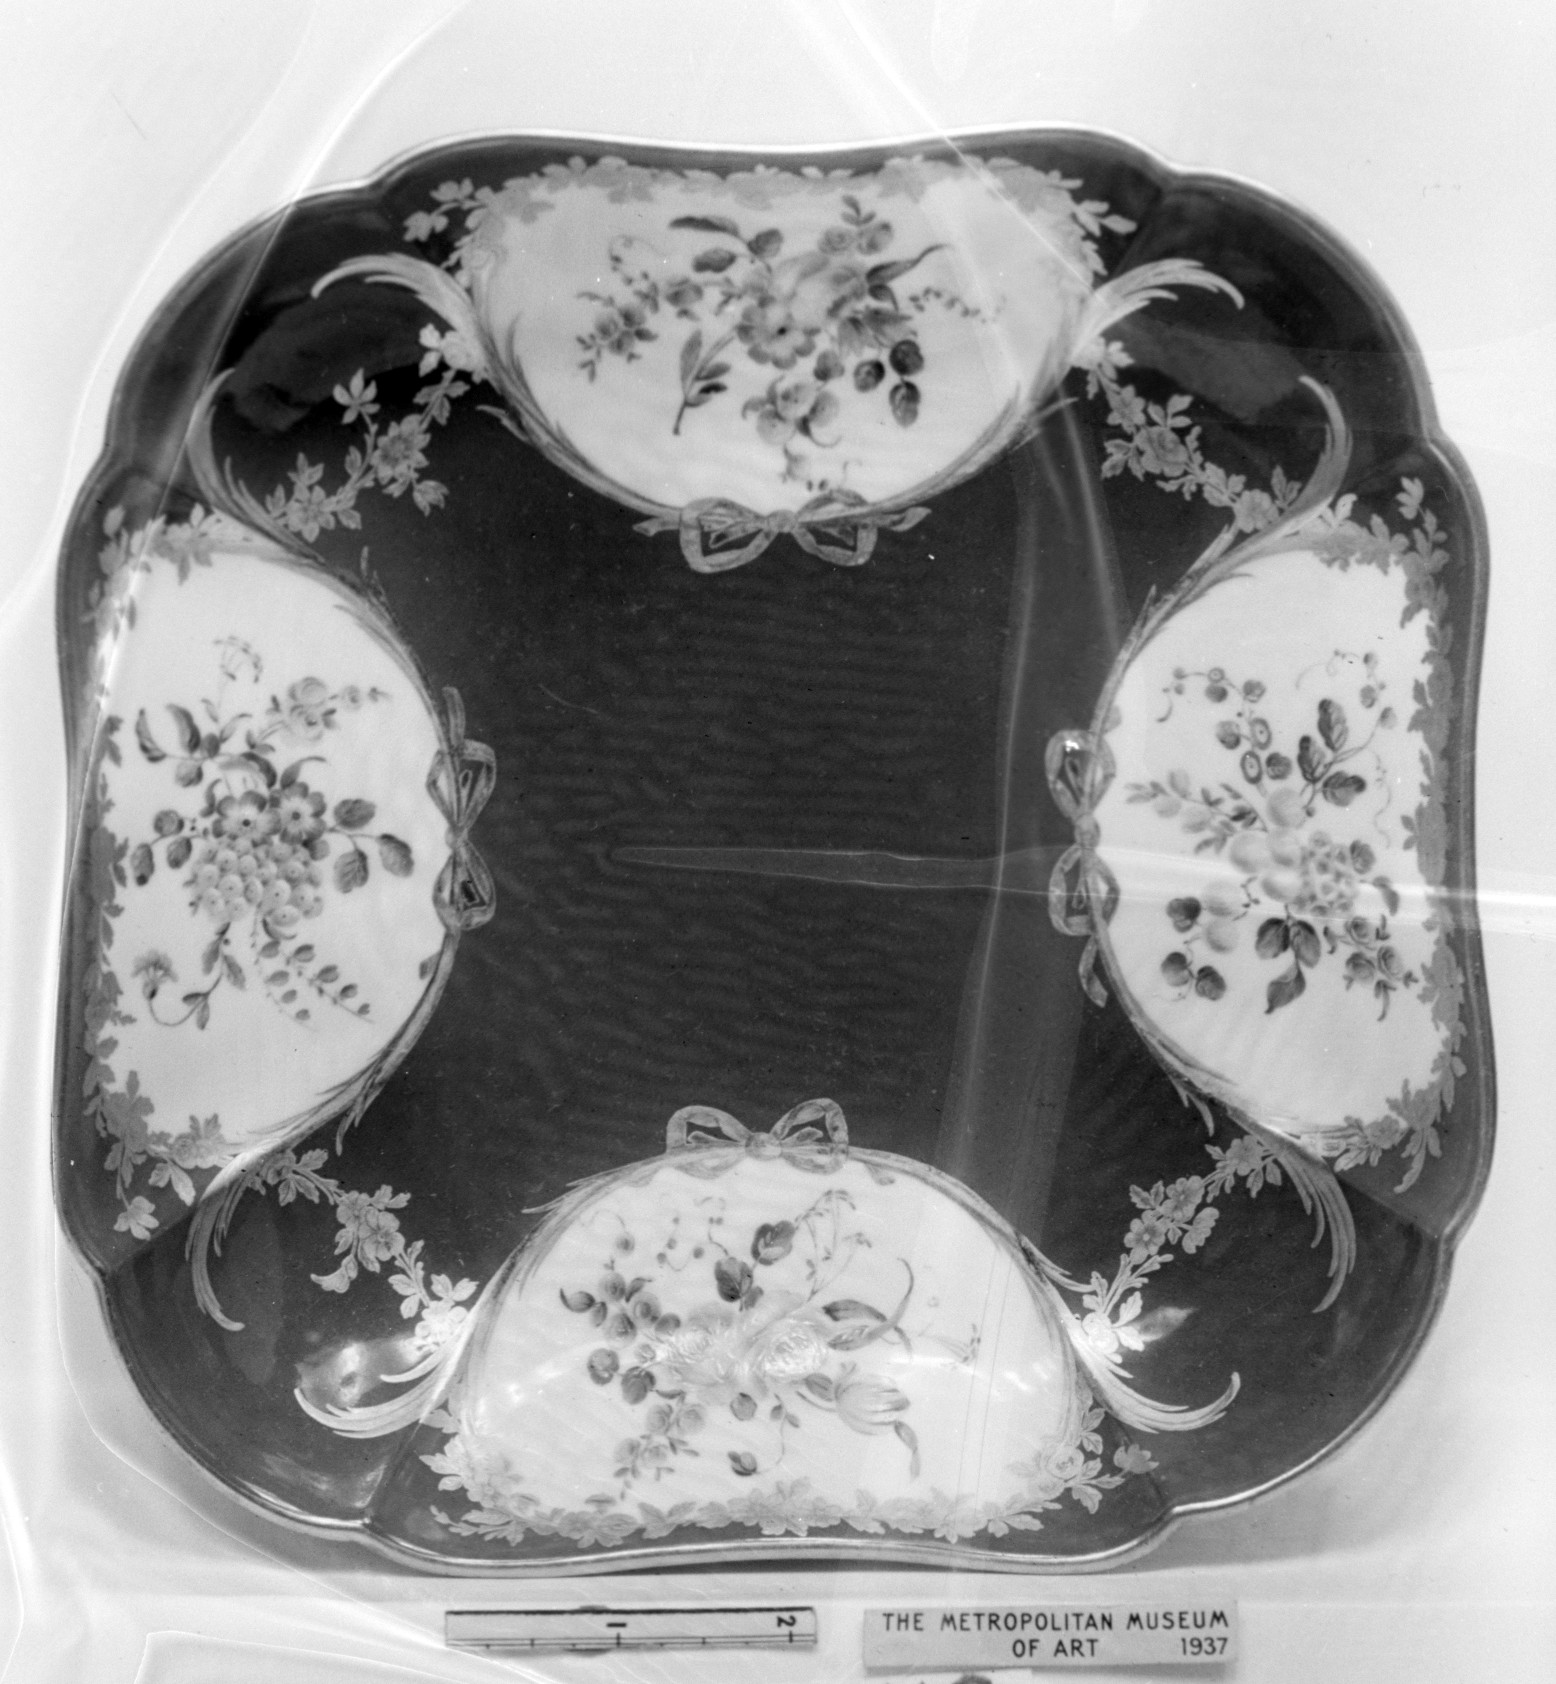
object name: fruit dish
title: Fruit dish (part of a service)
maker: sèvres manufactory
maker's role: manufactory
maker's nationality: french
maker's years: 1740-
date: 1772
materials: hard paste porcelain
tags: flowers